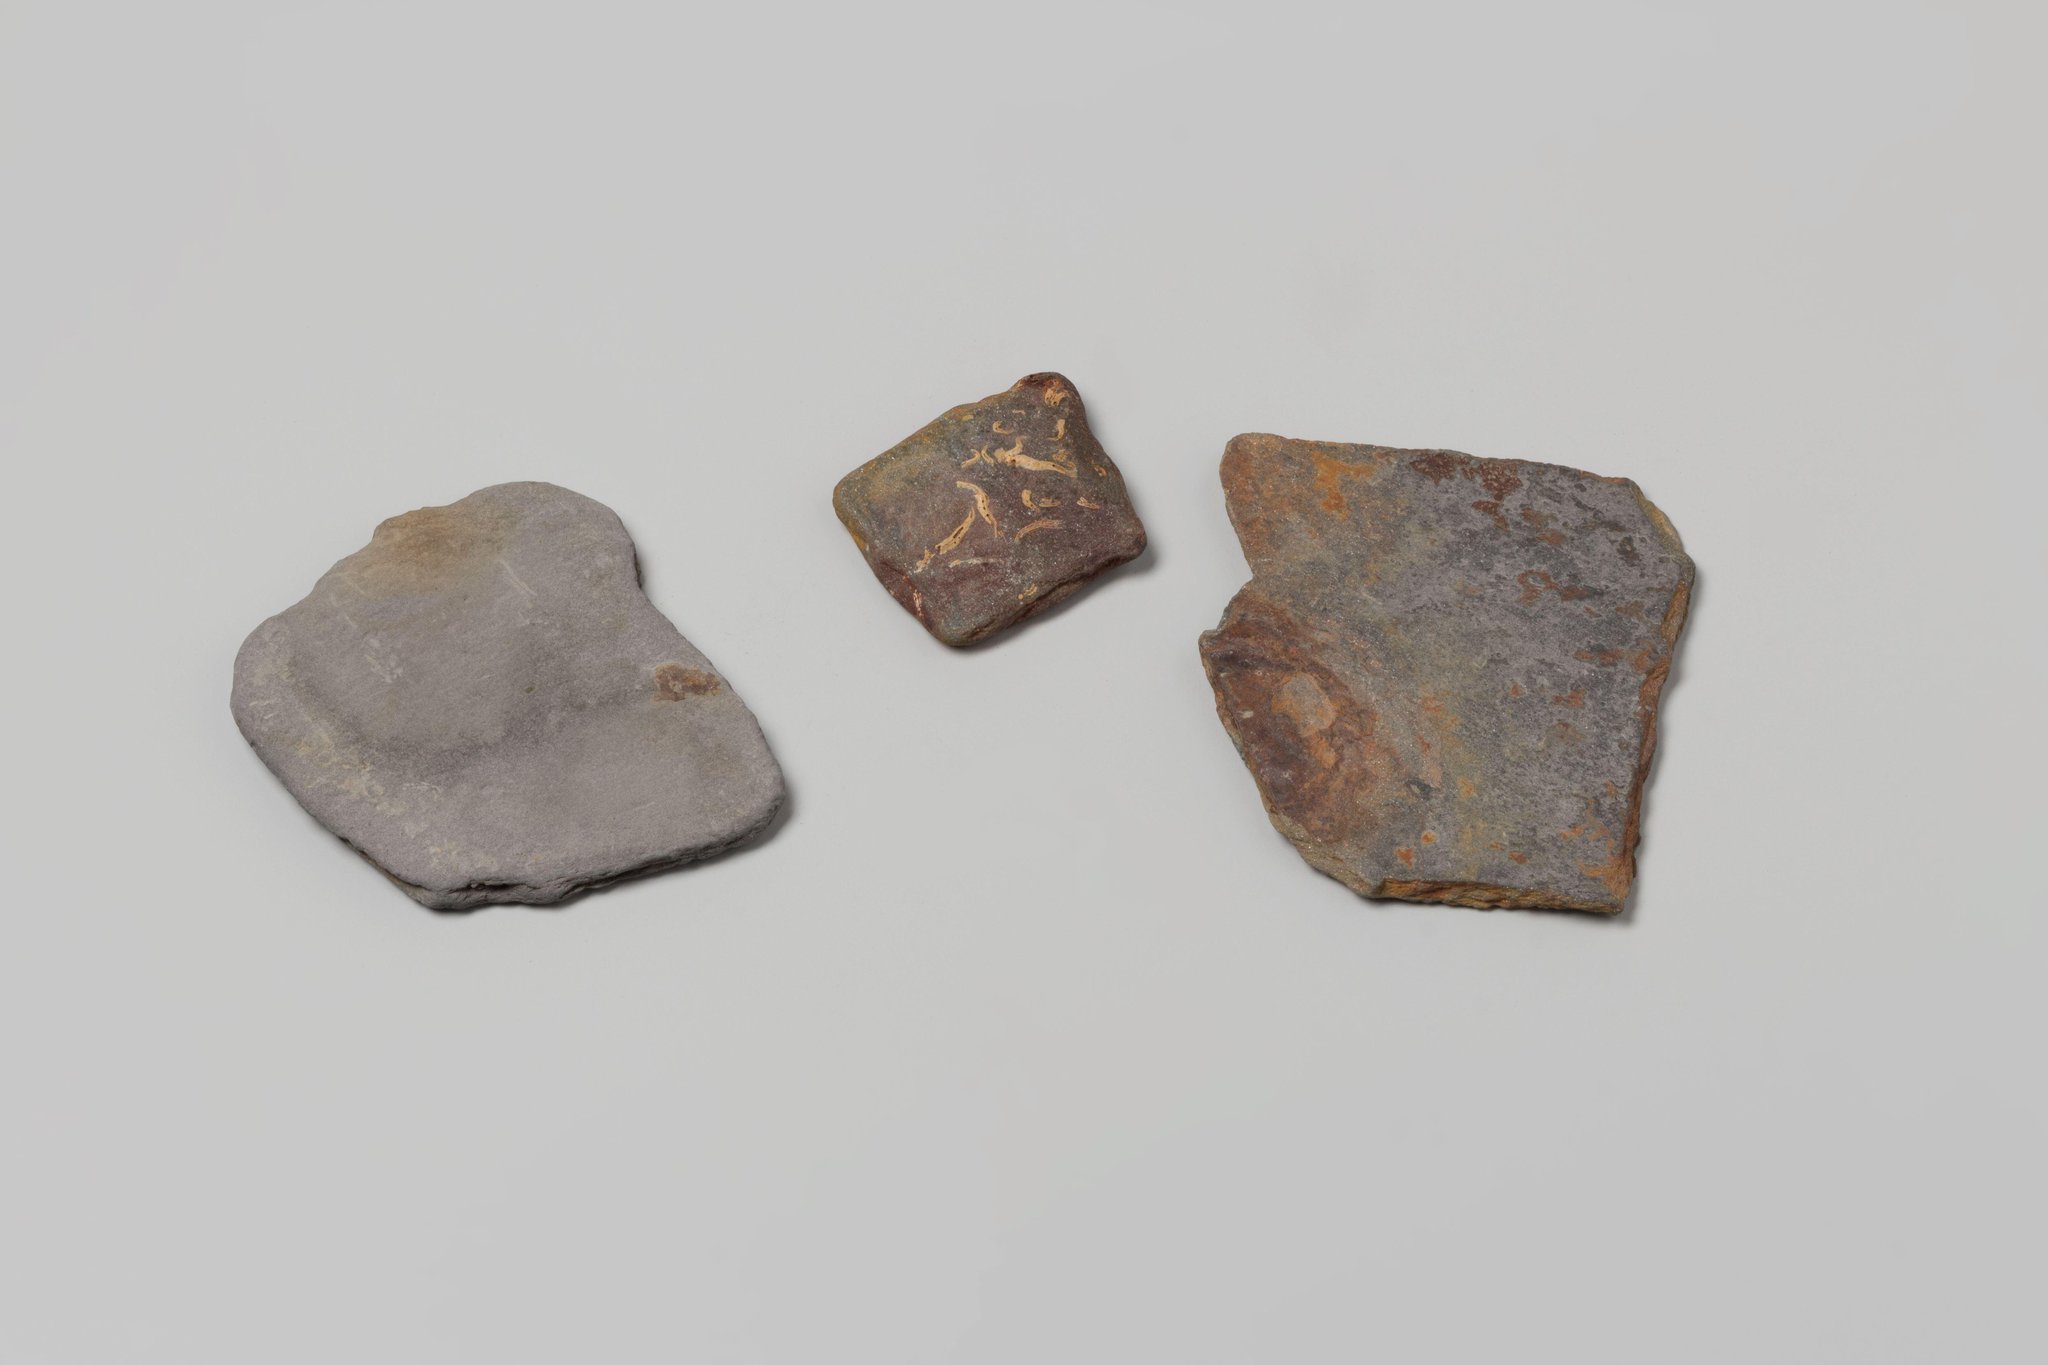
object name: scheepswrakvondst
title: Fragmenten leisteen uit het wrak van de Oost-Indiëvaarder Hollandia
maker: Anonymous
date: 1700-1743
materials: stone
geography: netherlands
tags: verenigde oostindische compagnie, hollandia (schip), annet